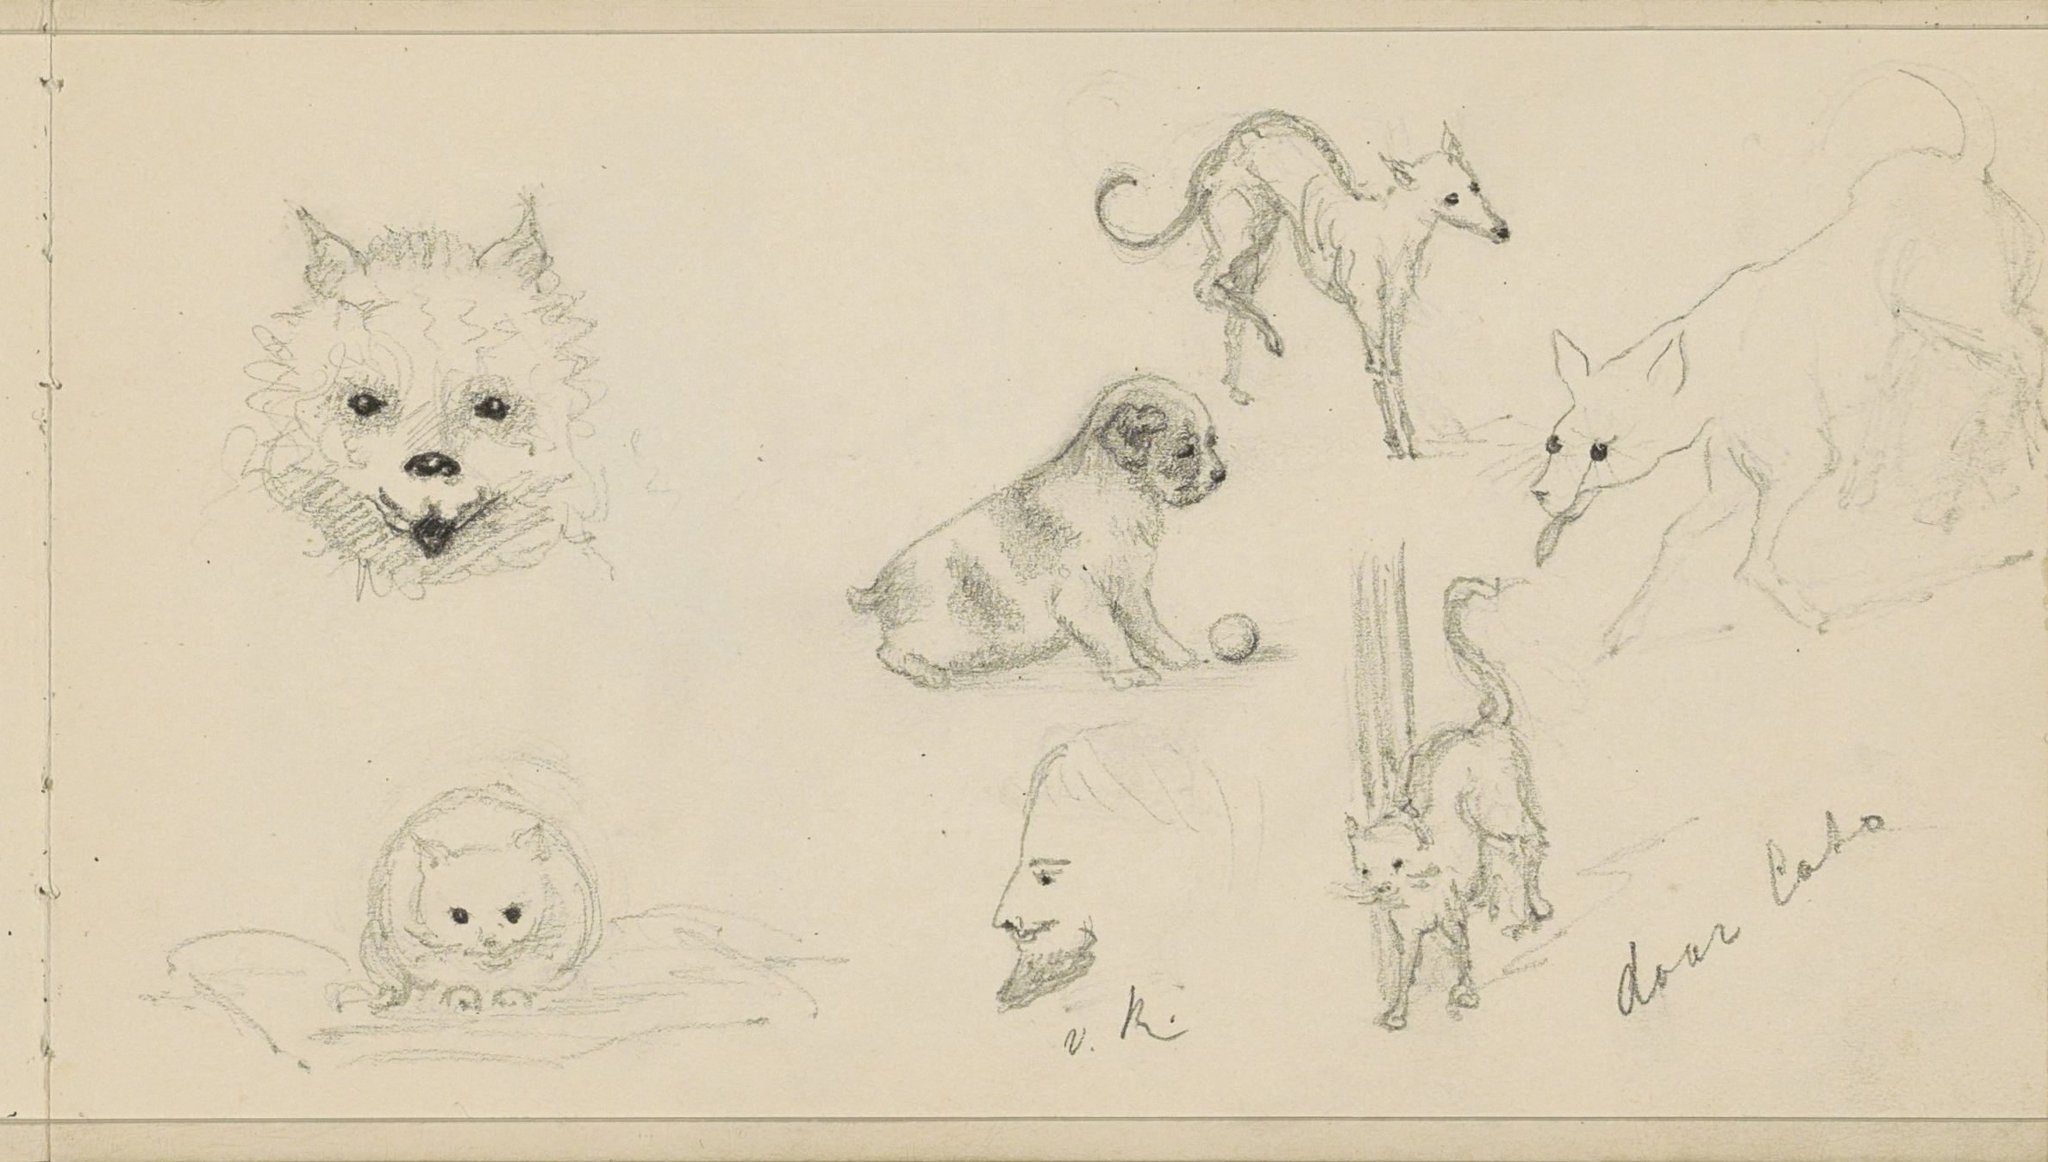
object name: sketchbook leaf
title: Honden, een kat en een mannenkop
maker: julie de graag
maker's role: draughtsman, print maker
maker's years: 1877-1924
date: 1892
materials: paper, pencil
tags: head (human), cat, adult man, dog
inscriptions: annotation: ‘v . R./ door Cato’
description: Blad 3 recto uit een schetsboek met 22 bladen.